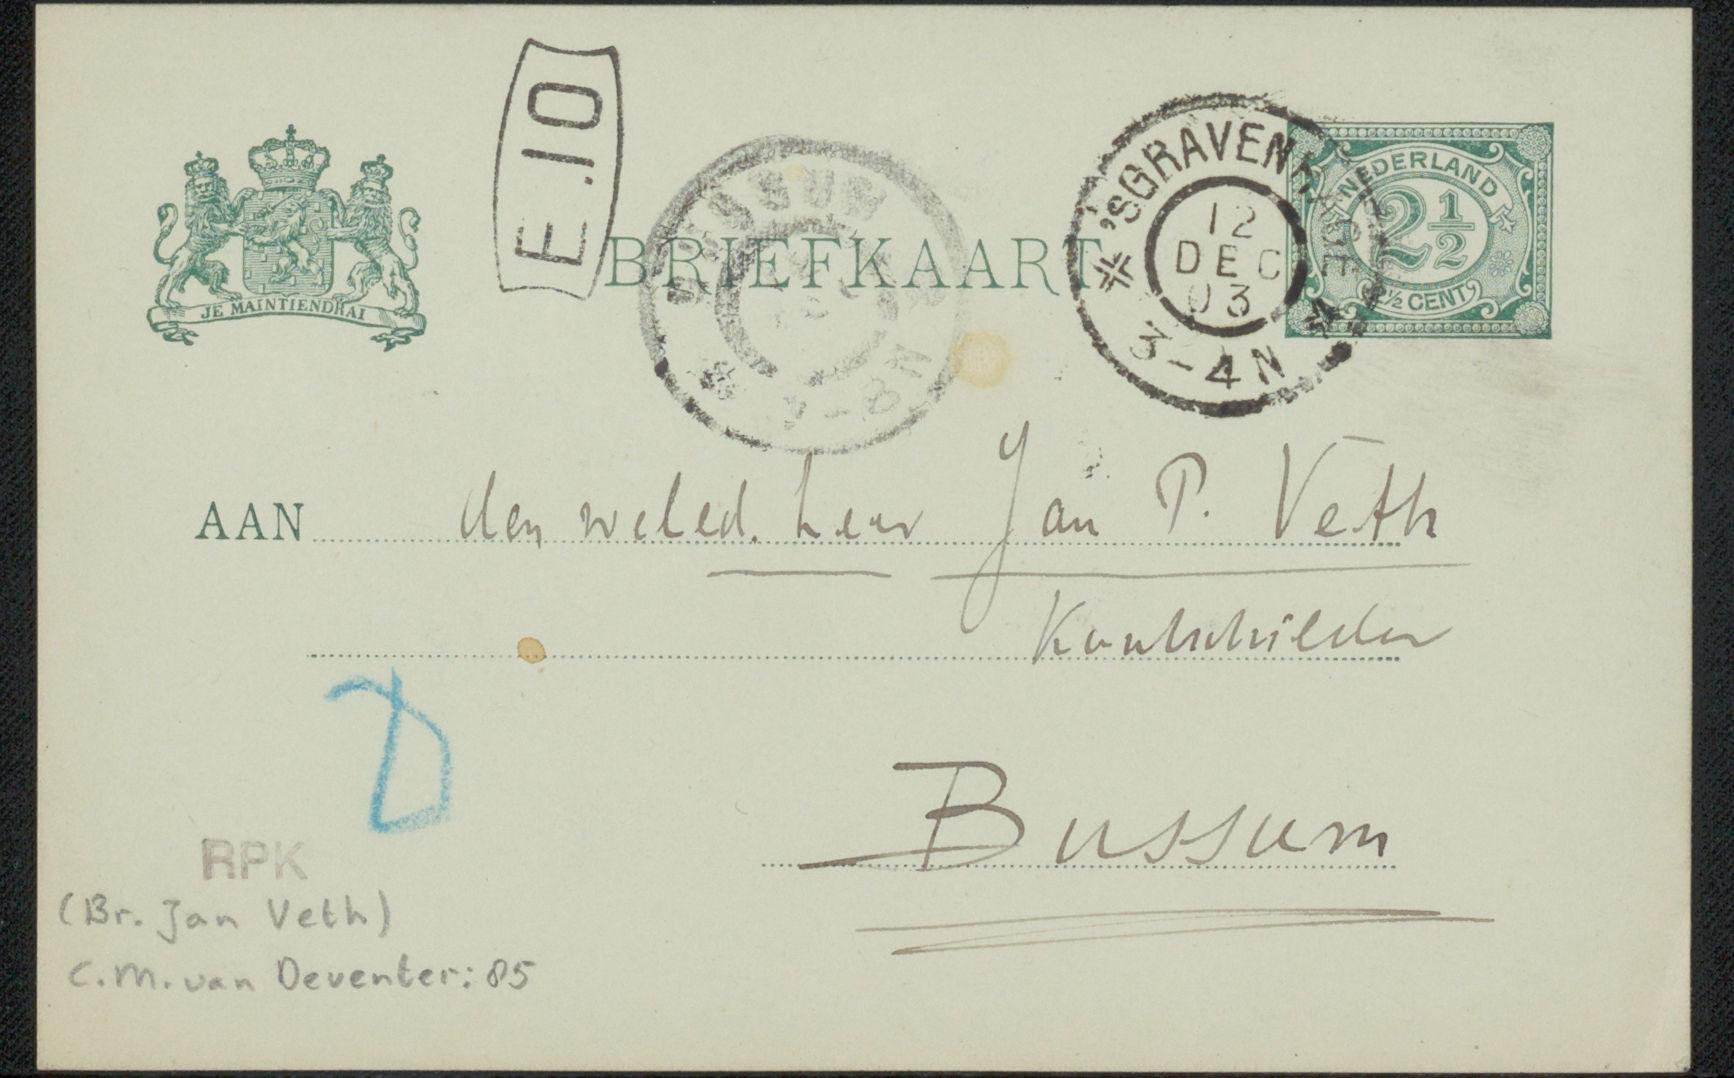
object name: postcard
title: Briefkaart aan Jan Veth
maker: chap van deventer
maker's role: kunstcriticus, scheikundige, schrijver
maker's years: 1860-1931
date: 1903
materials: cardboard, ink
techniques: pen, writing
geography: the hague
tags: designer, jan veth, leiden, amsterdam, painter, print maker, draughtsman, rembrandt van rijn, peter paul rubens, literature ~ arts, printed matter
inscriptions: collector's mark: ‘RPK’